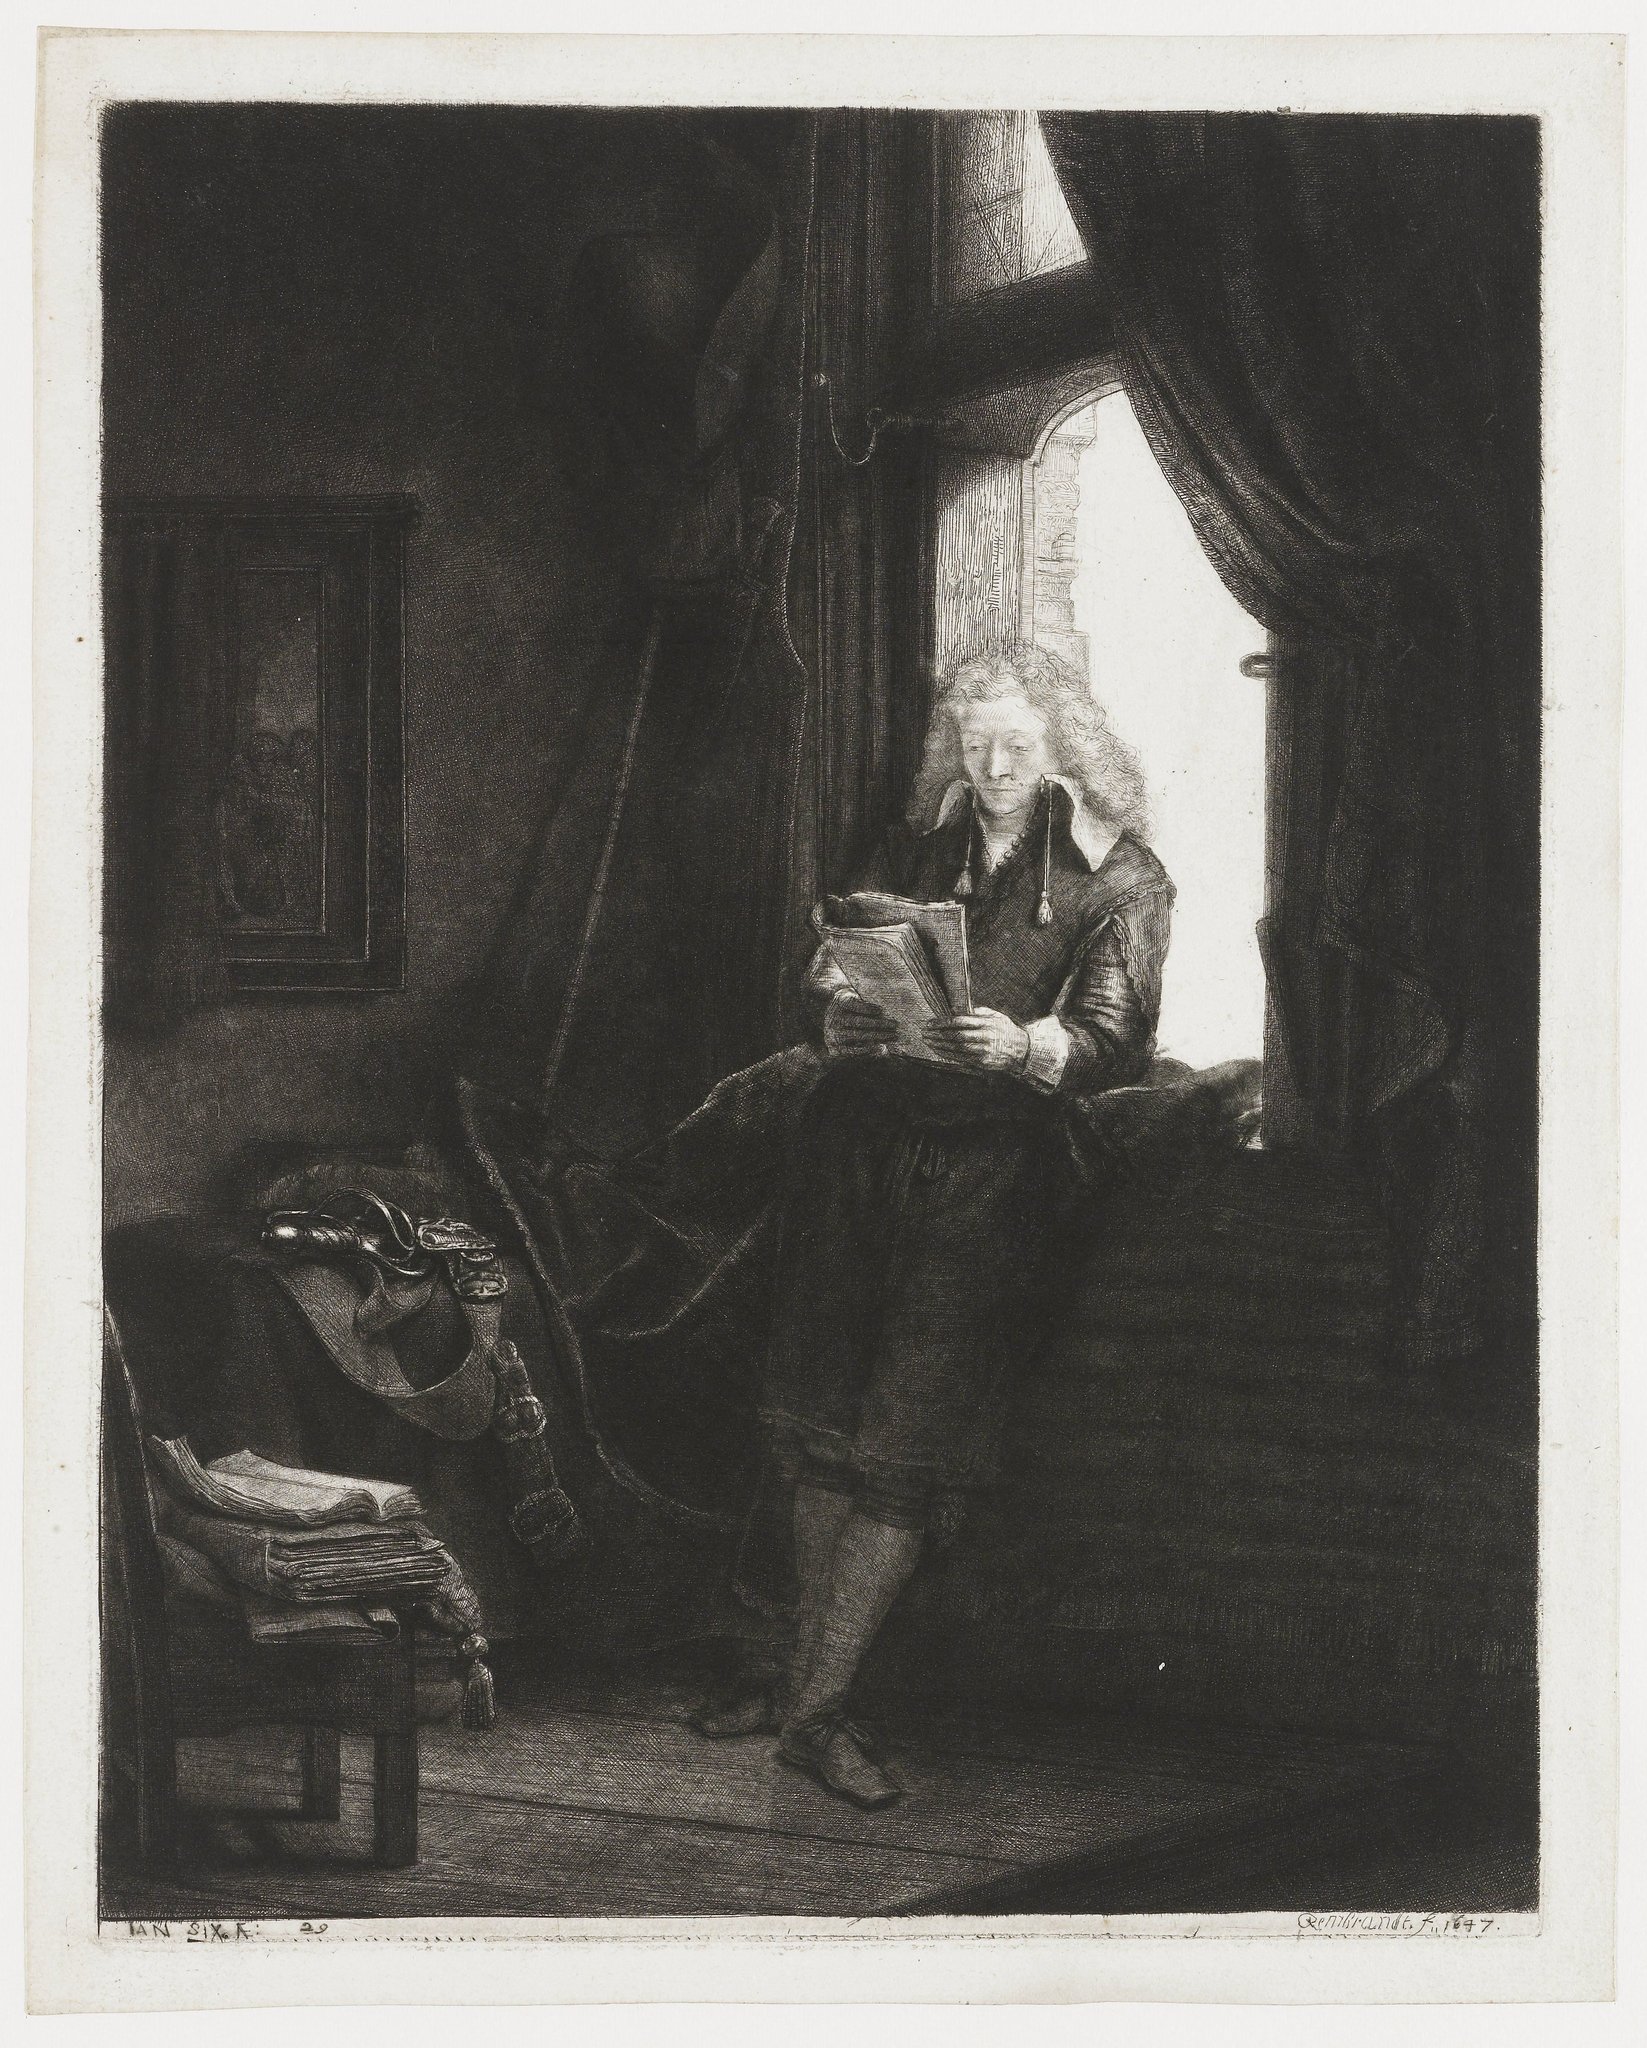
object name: print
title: Jan Six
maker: rembrandt van rijn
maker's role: draughtsman, painter, print maker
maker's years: 1606-1669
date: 1647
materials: paper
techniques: drypoint, etching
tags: amsterdam, mayor, jan six (1618-1700), mayor, burgomaster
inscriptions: signature and date: ‘Rembrandt. f.. 1647’, mark: Lugt 2228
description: Rembrandt was befriended for some time with the well-to-do Jan Six, who later served as mayor of Amsterdam. He portrays him here in a highly informal manner, standing near an open window and reading a book. The detailed, skilful rendering of the dark room, in particular, is an unsurpassed feat in the art of etching.